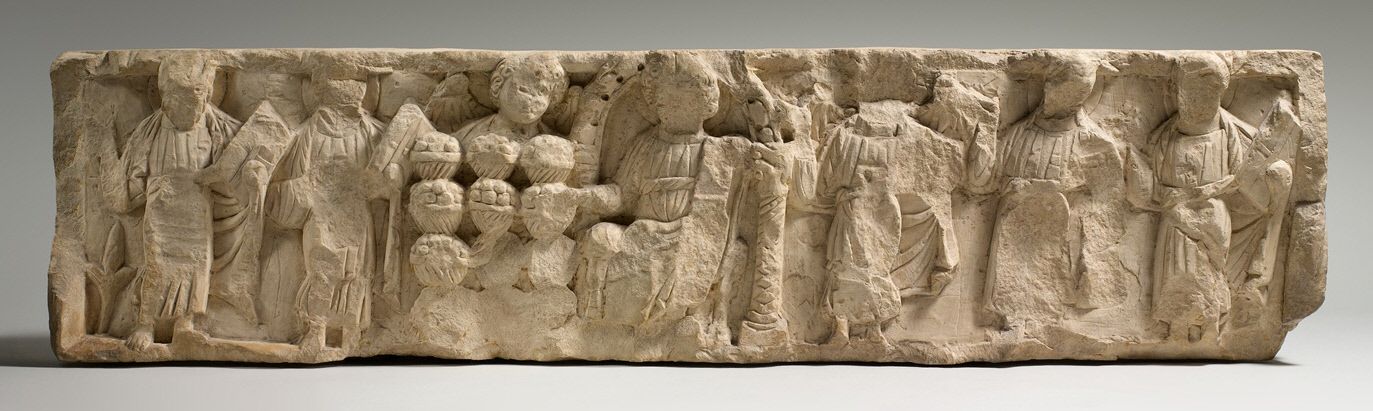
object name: frieze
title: Fragment of a Frieze with the Miracle of Loaves and Fishes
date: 501-700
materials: limestone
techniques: carving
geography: egypt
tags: angels,christ